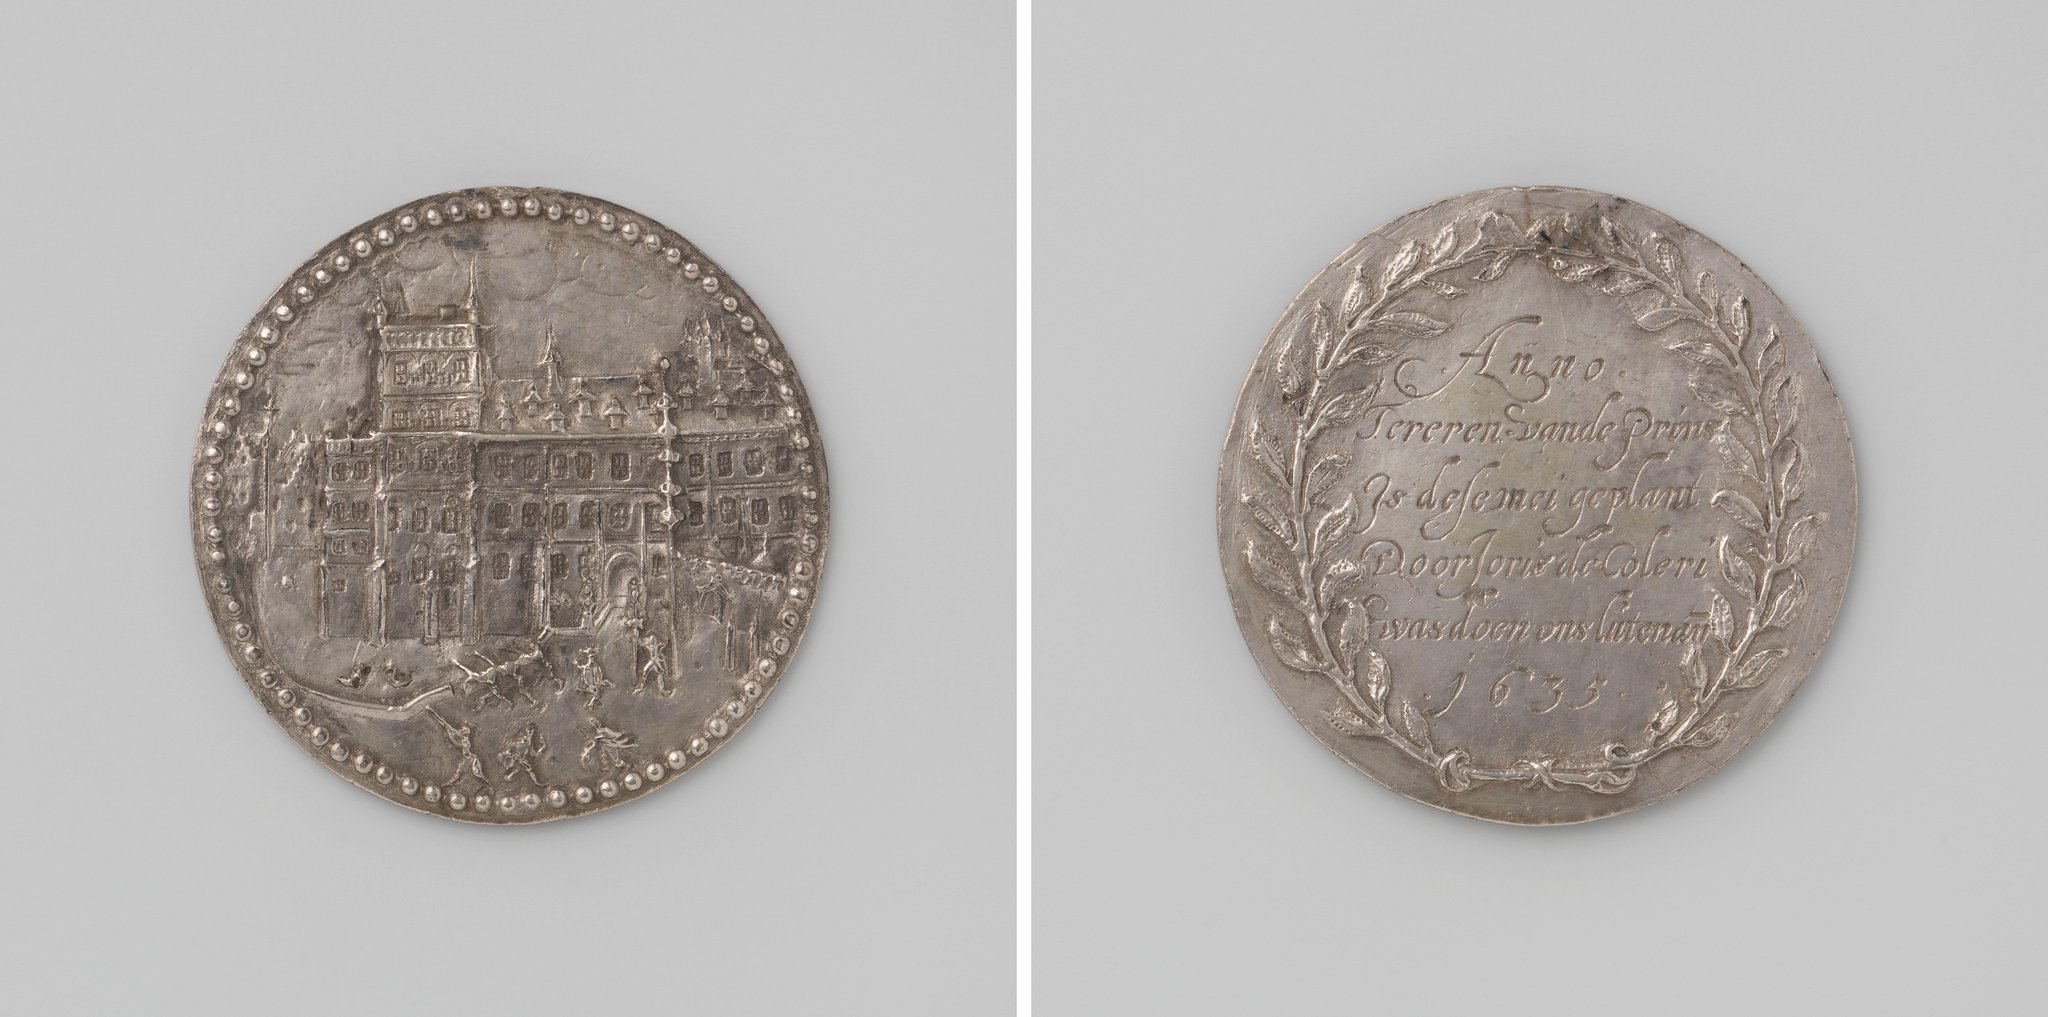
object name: history medal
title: Planten van de meiboom te Den Haag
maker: Anonymous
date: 1635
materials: silver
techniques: engraving, striking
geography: the hague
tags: the hague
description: Zilveren penning. Voorzijde: gezicht op het Buitenhof met de meiboom; opschrift binnen lauwerkrans